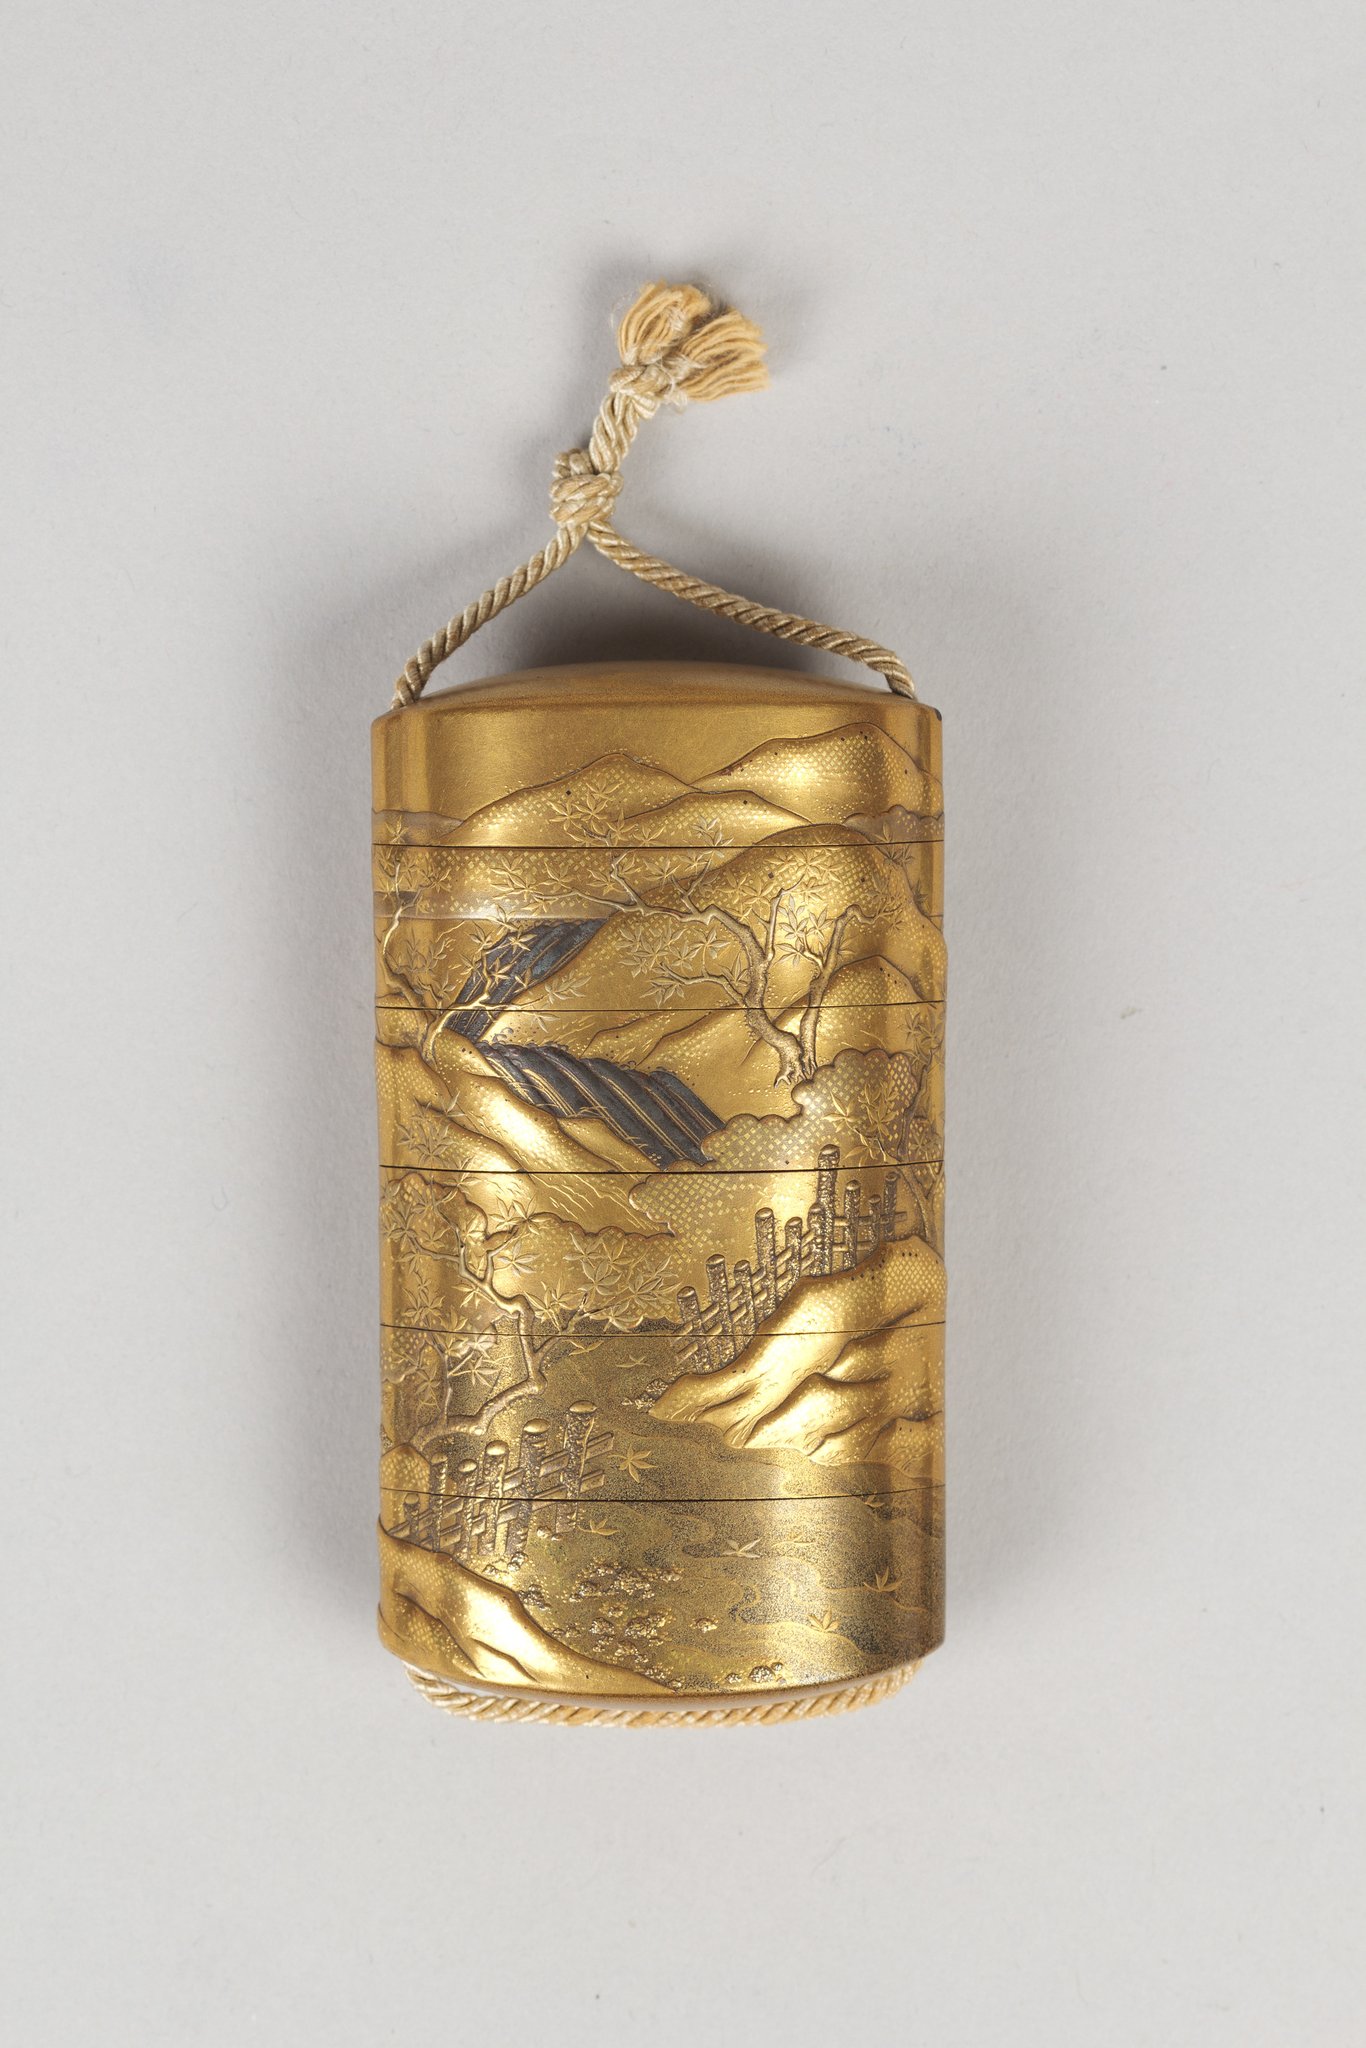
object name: inrō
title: Case (Inrō) with Design of River in Spring with Flowering Cherry Trees (obverse); River in Autumn with Maple Leaves (reverse)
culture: japanese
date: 1801-1900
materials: lacquer, silver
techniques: fundame, hiramakie, maki-e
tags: rivers,mountains,trees